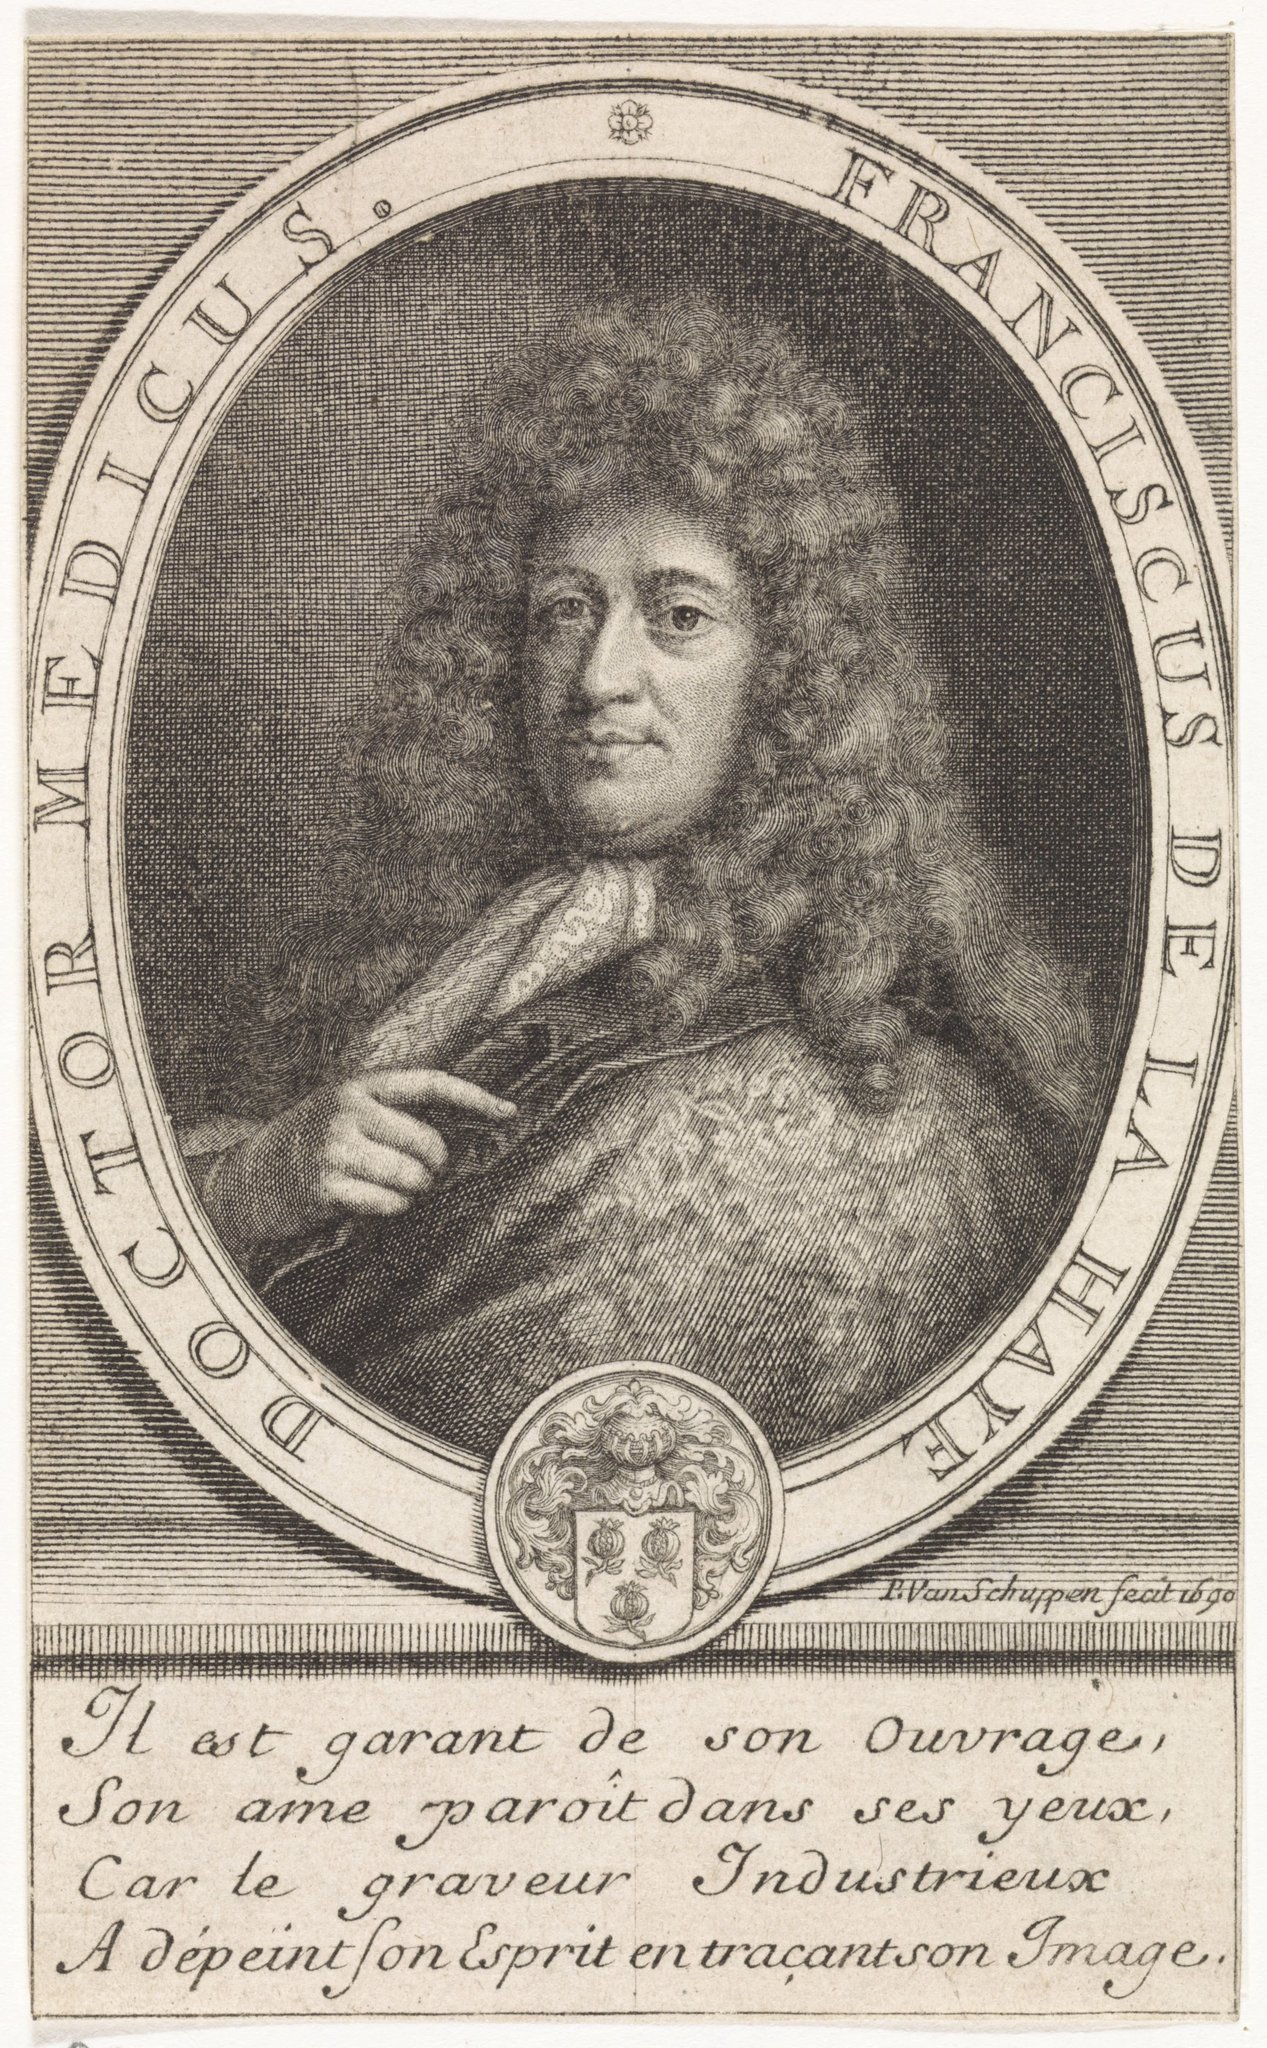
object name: print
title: Portret van François de la Haye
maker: pieter van schuppen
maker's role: print maker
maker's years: 1627-1702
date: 1690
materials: paper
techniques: etching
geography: paris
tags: françois de la haye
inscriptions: collector's mark: Lugt 2228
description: Portret van de arts François de la Haye. Onder de afbeelding zijn wapenschild en een gedicht in het Frans.